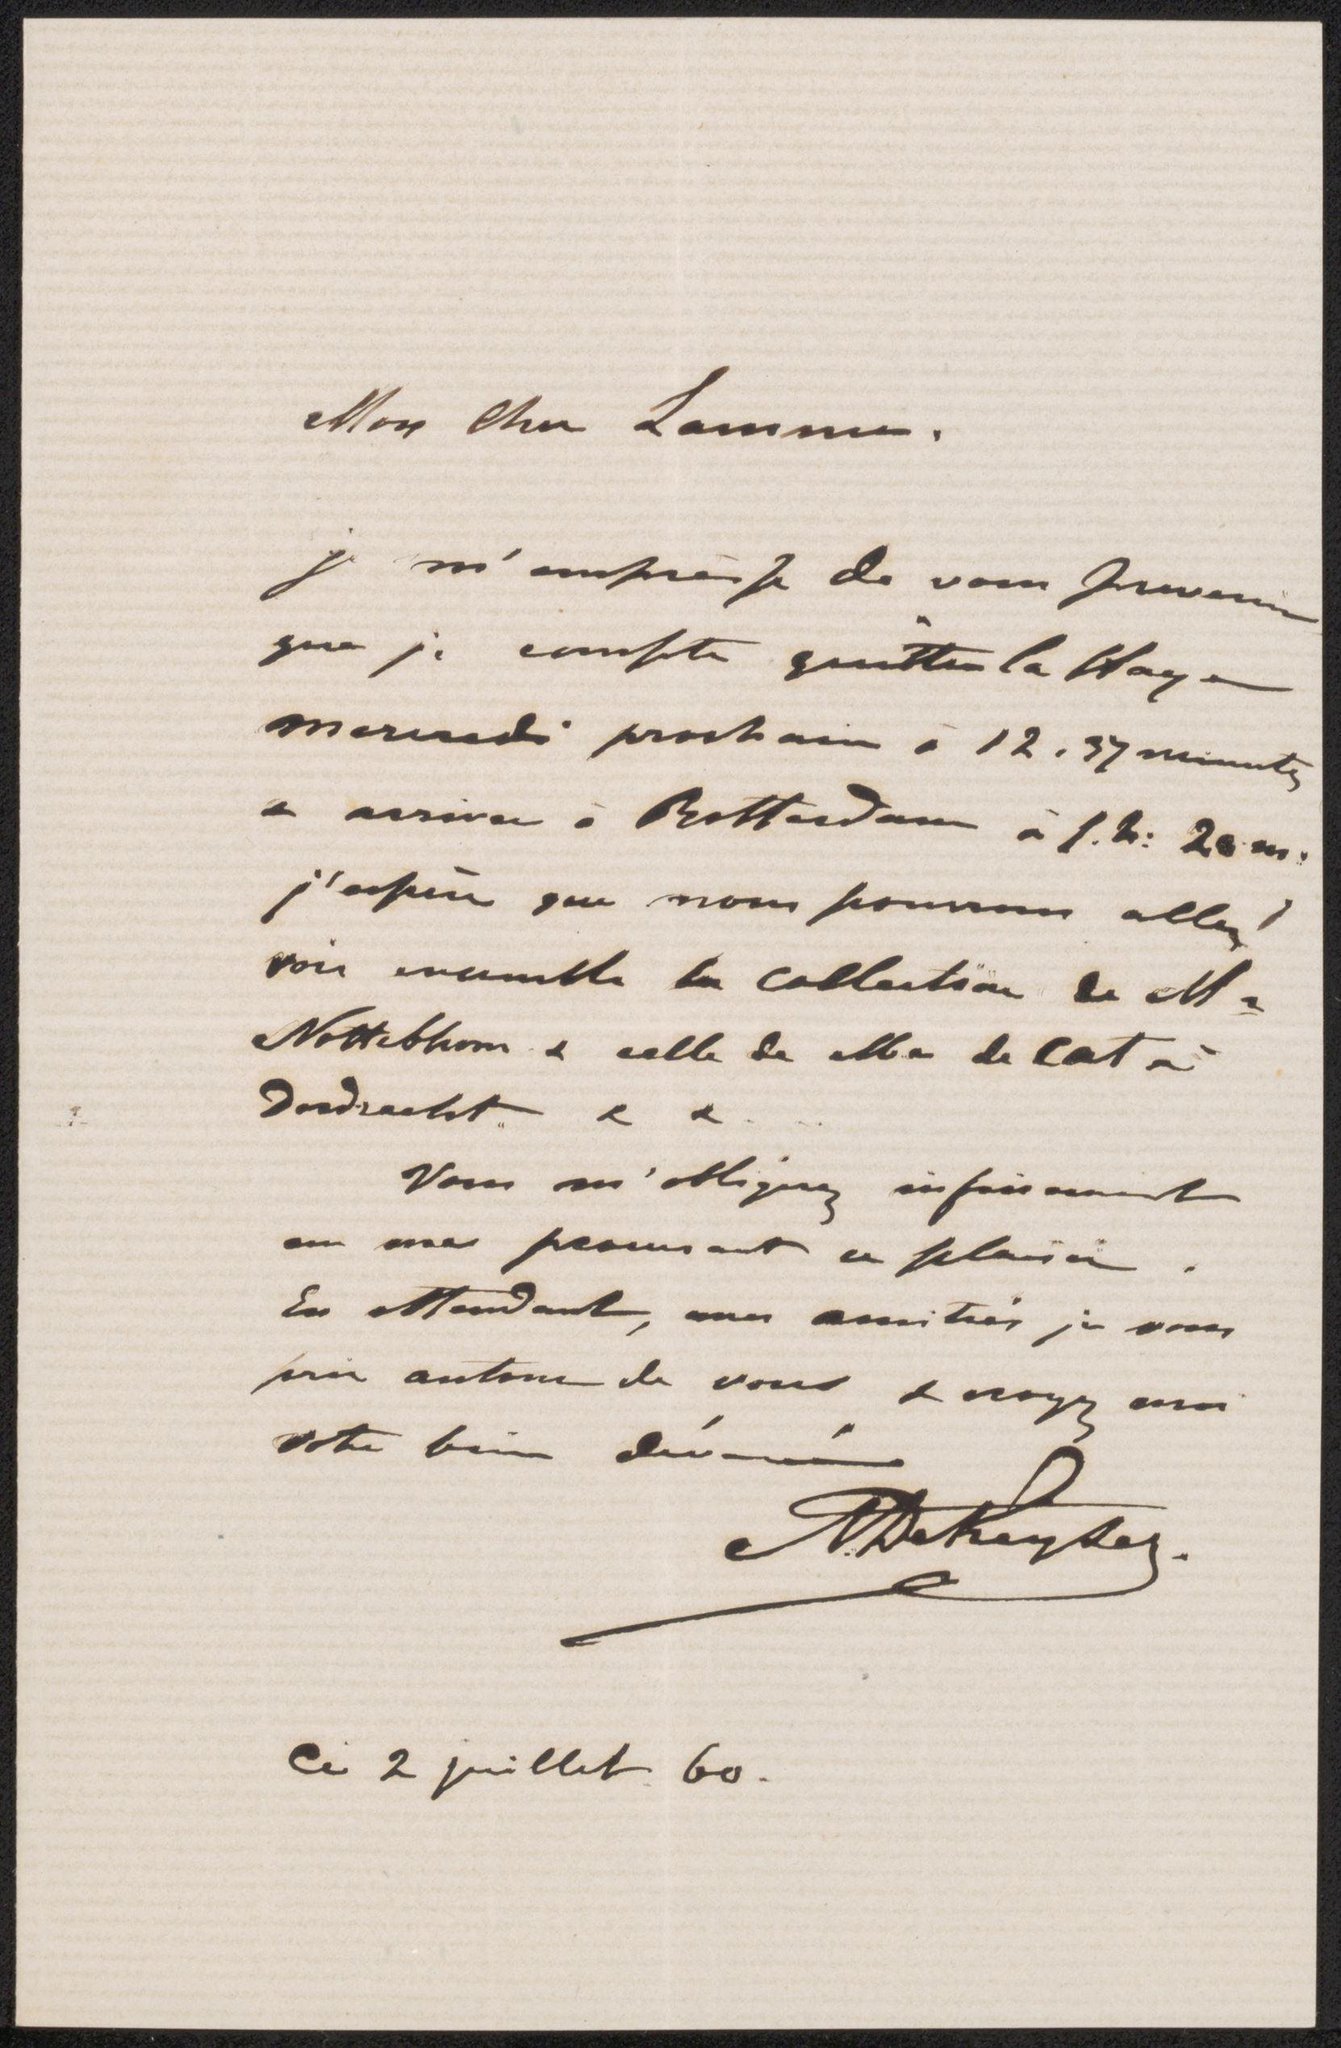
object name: letter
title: Brief aan Ary Johannes Lamme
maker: nicaise de keyser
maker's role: draughtsman, painter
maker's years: 1813-1887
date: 1860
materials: ink, paper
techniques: pen, writing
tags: delfshaven, dordrecht, print maker, draughtsman, ary johannes lamme, art collecting, the hague, rotterdam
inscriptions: collector's mark: Lugt 2228